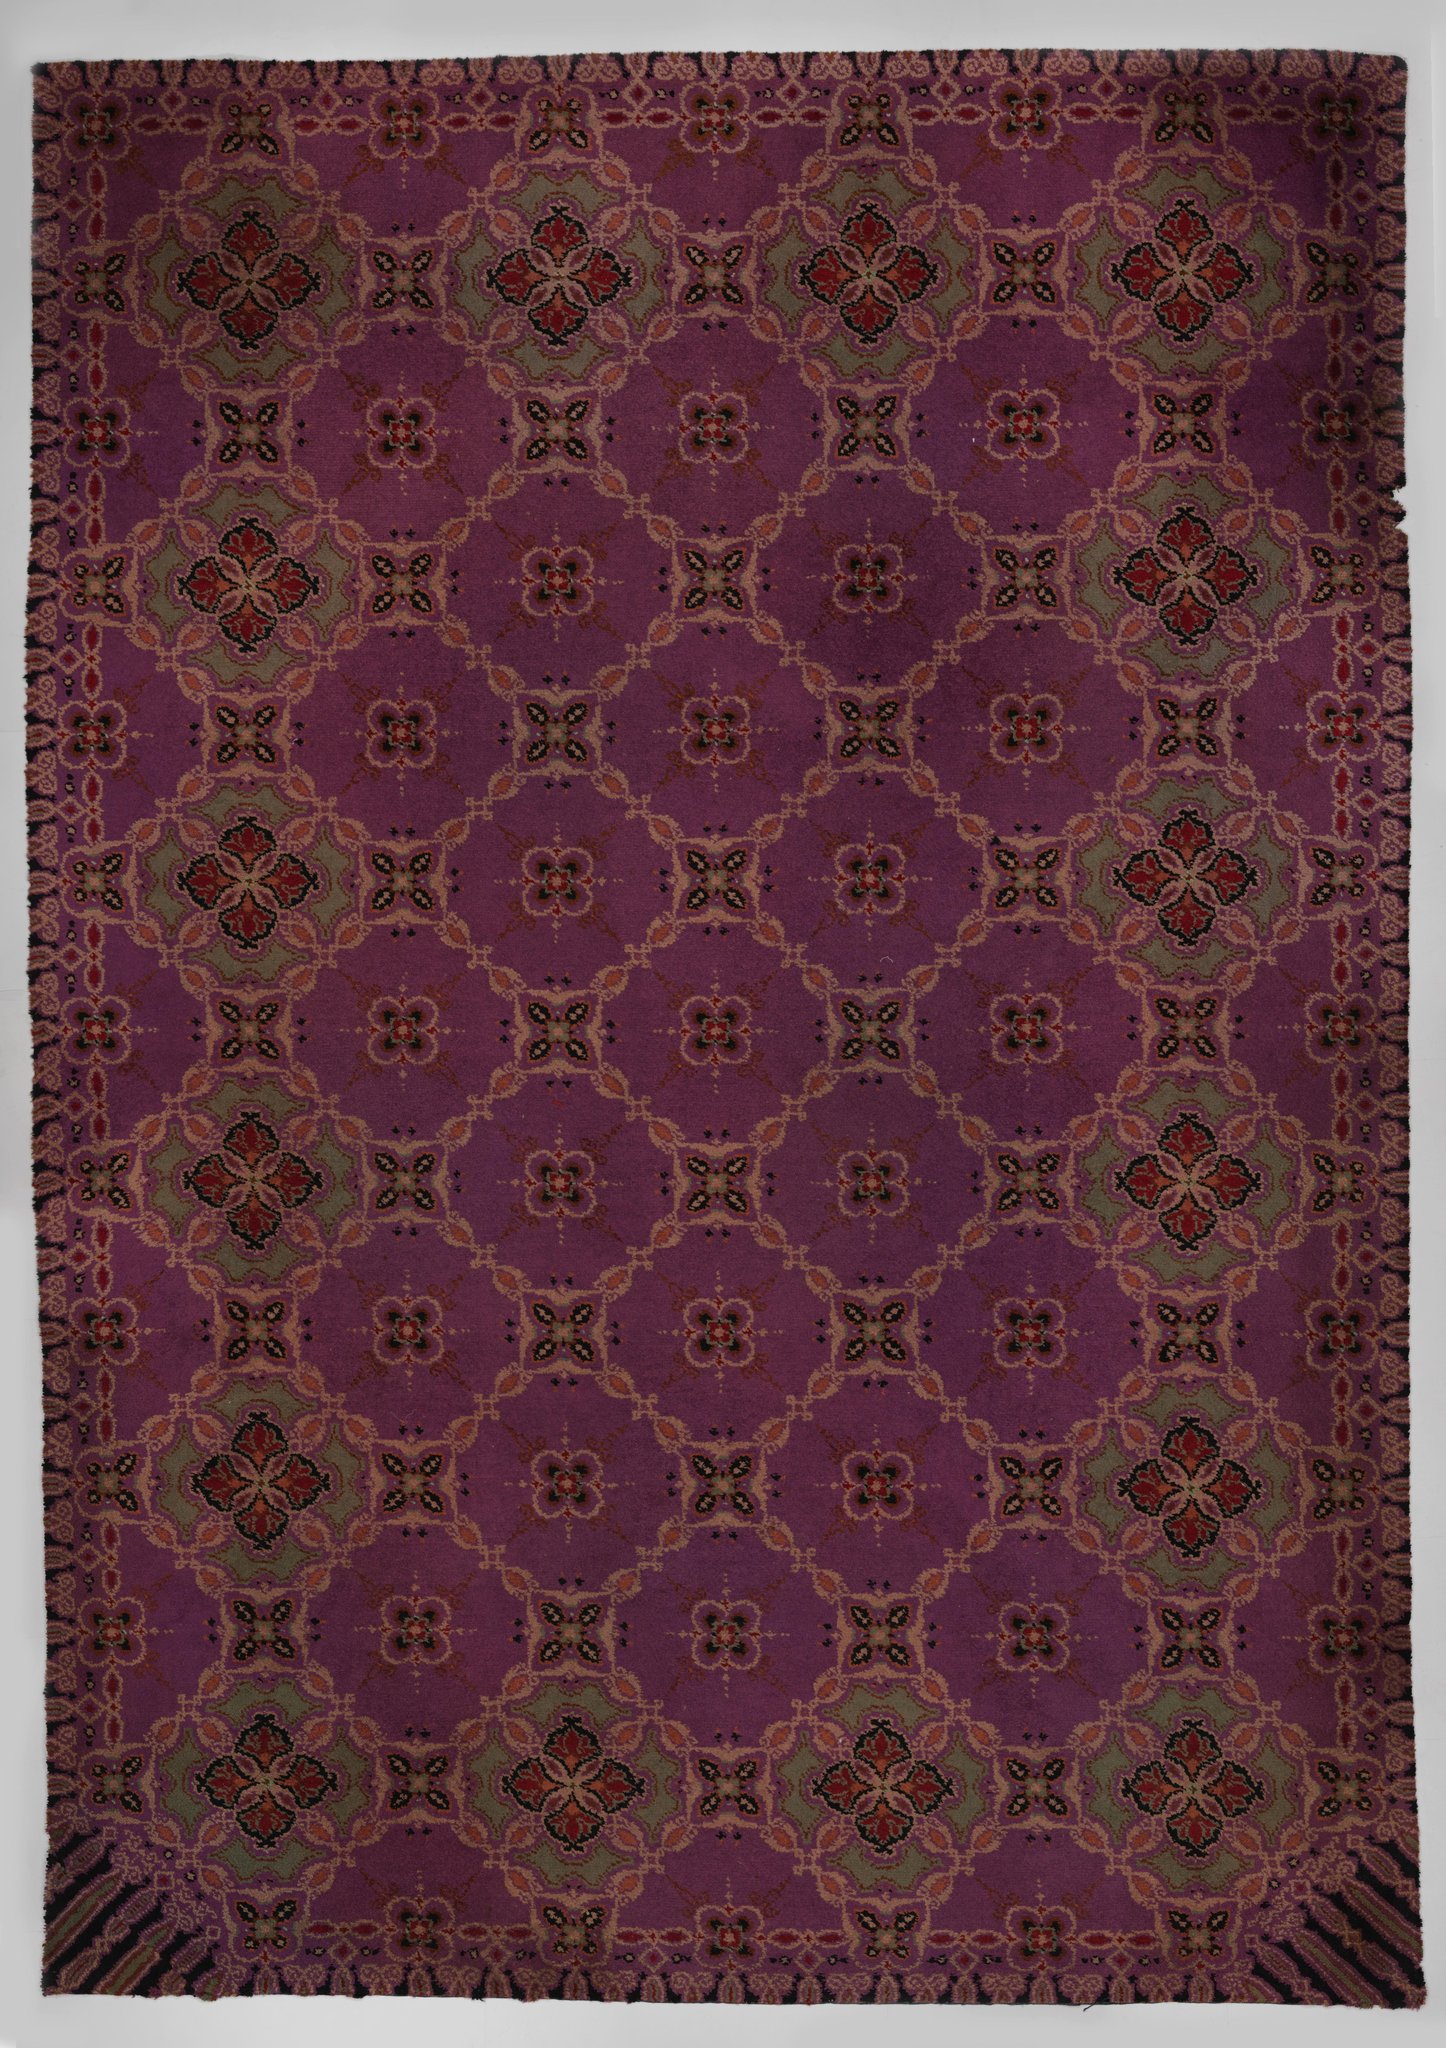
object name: kleed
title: Vloerkleed, behorende bij ameublement ontwerp Jan de Meyer. Violet fond.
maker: jan de meijer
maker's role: designer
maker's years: 1878-1950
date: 1925-1929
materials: wool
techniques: knotting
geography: deventer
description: Vloerkleed, behorende bij ameublement ontwerp Jan de Meyer. Violet fond. Opmerking: enkele stukken van het ameublement werden ons in 1973 reeds geschonken door de heer en mevrouw Loeb-Levenbach te Voorschoten. Westers vloerkleed.